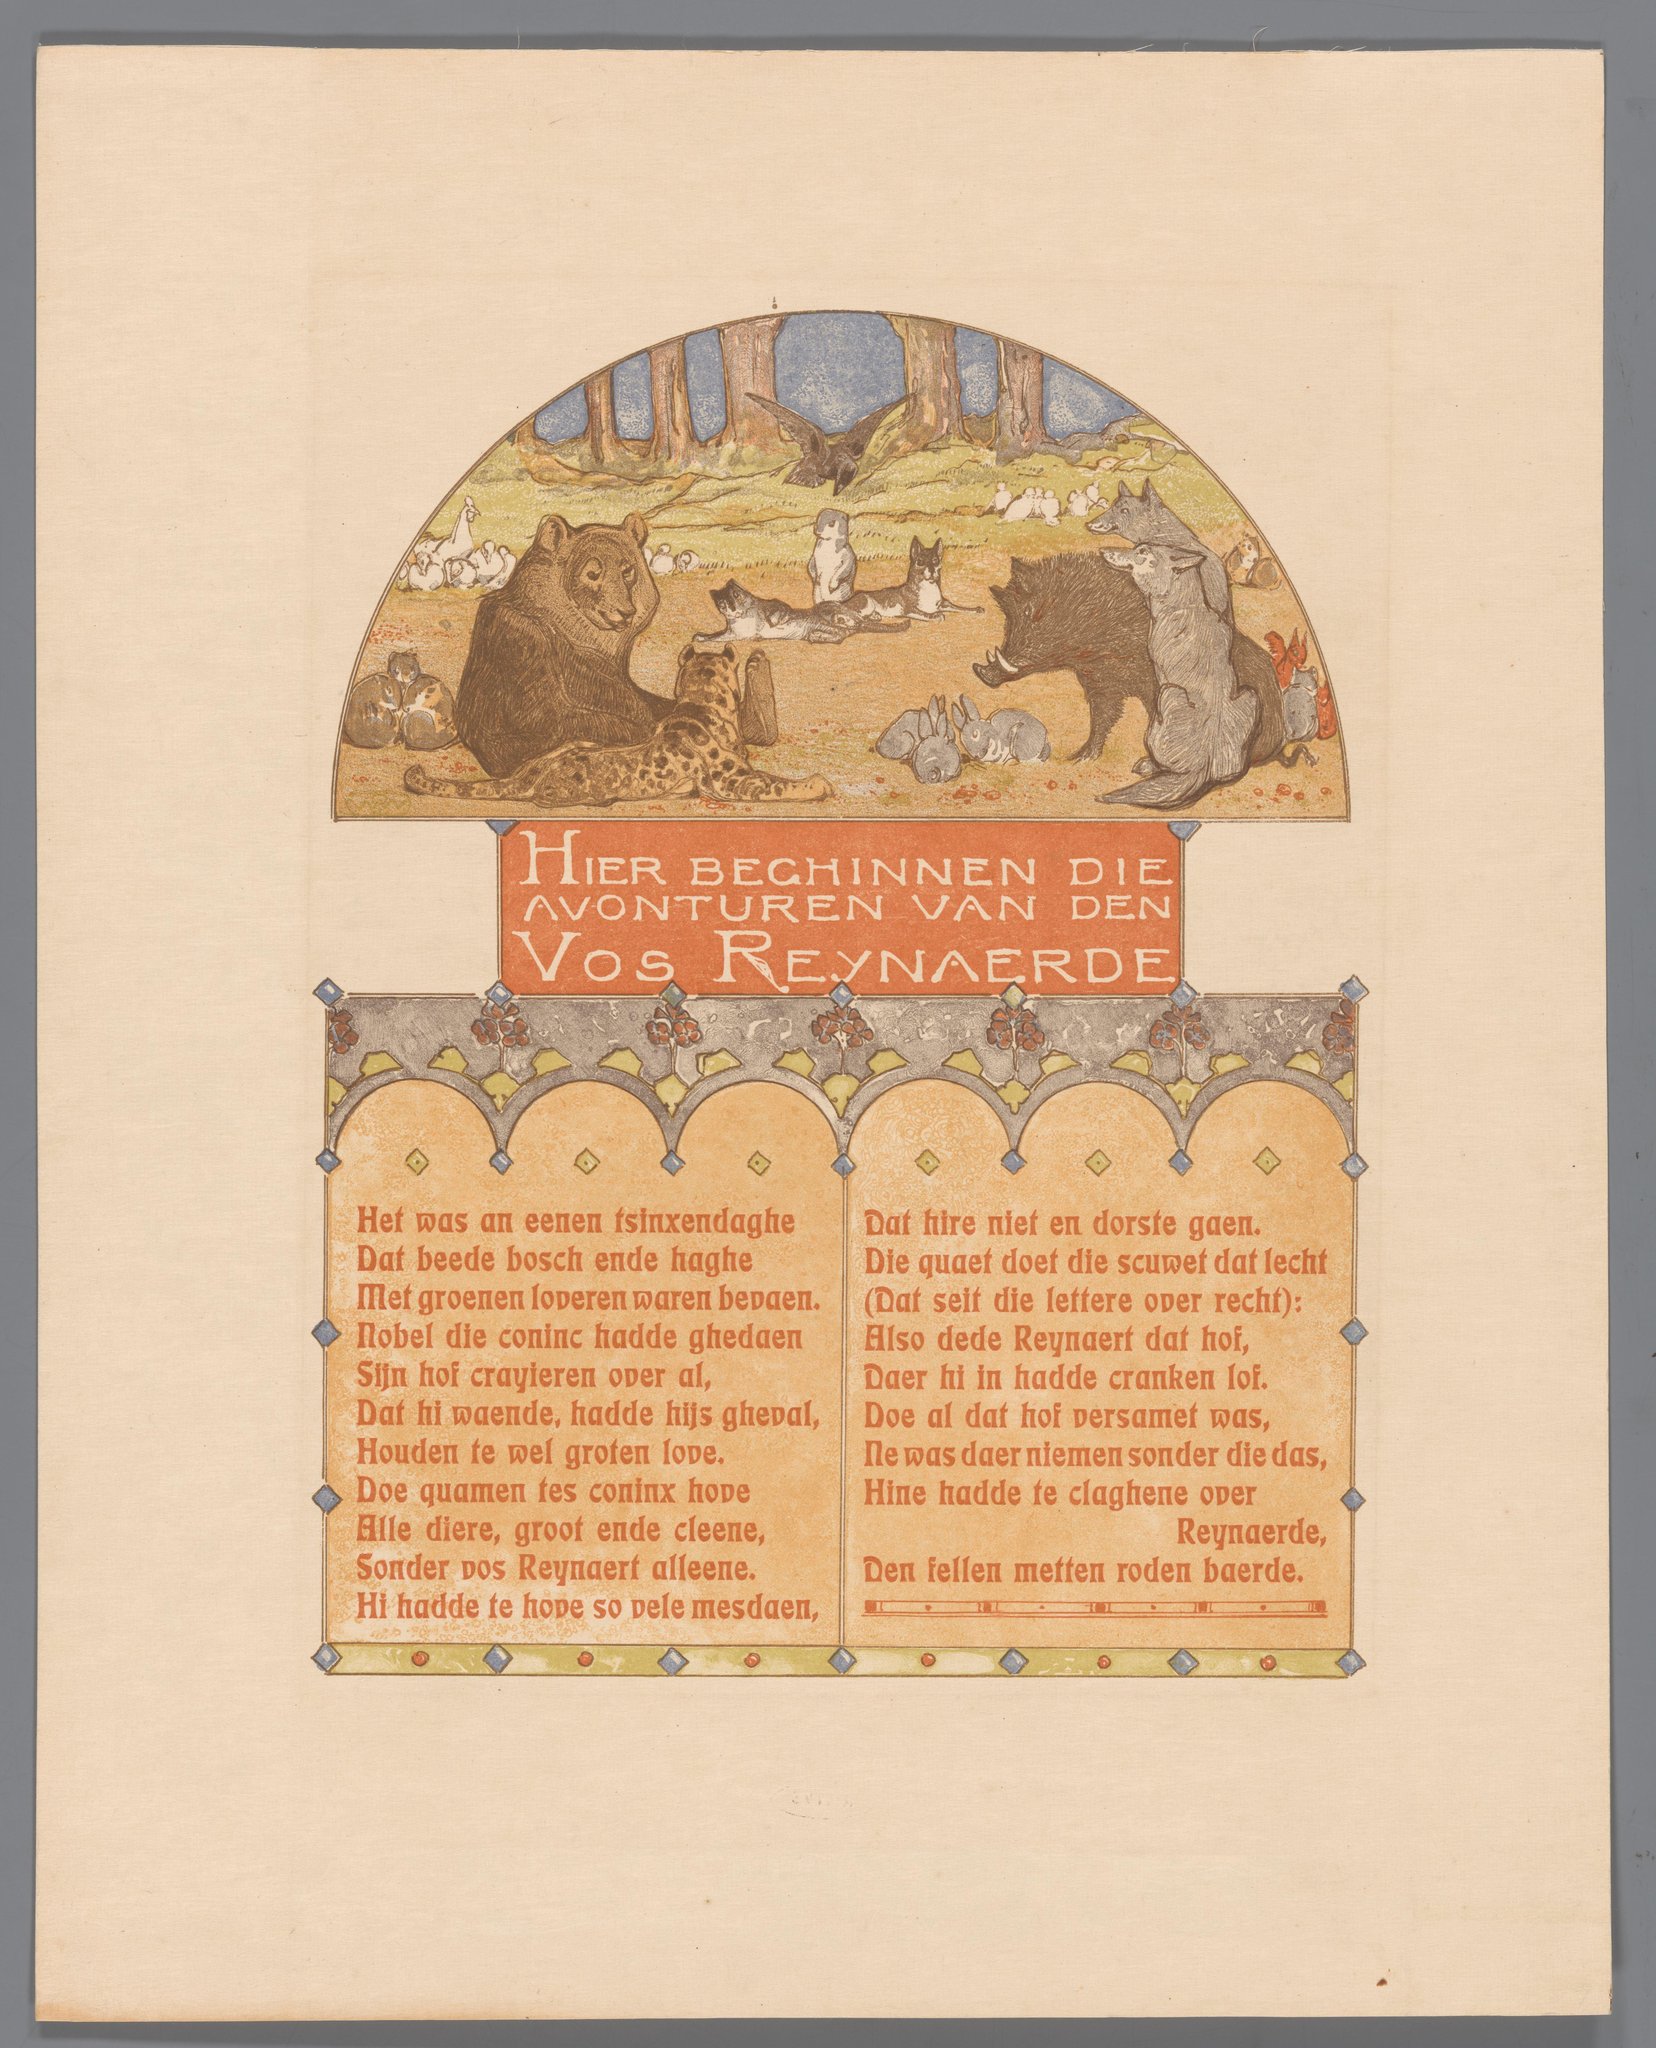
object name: print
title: Groep dieren uit Reinaert de Vos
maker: bernard willem wierink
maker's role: draughtsman, print maker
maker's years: 1856-1939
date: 1910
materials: paper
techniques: lithograph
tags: fable of reynard the fox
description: Prent gebruikt in: Streuvels, Stijn (Frank Lateur). Reinaert de Vos naar verschillende uitgaven van het middeleeuwsche epos. Amsterdam: L.J. Veen, 1910.